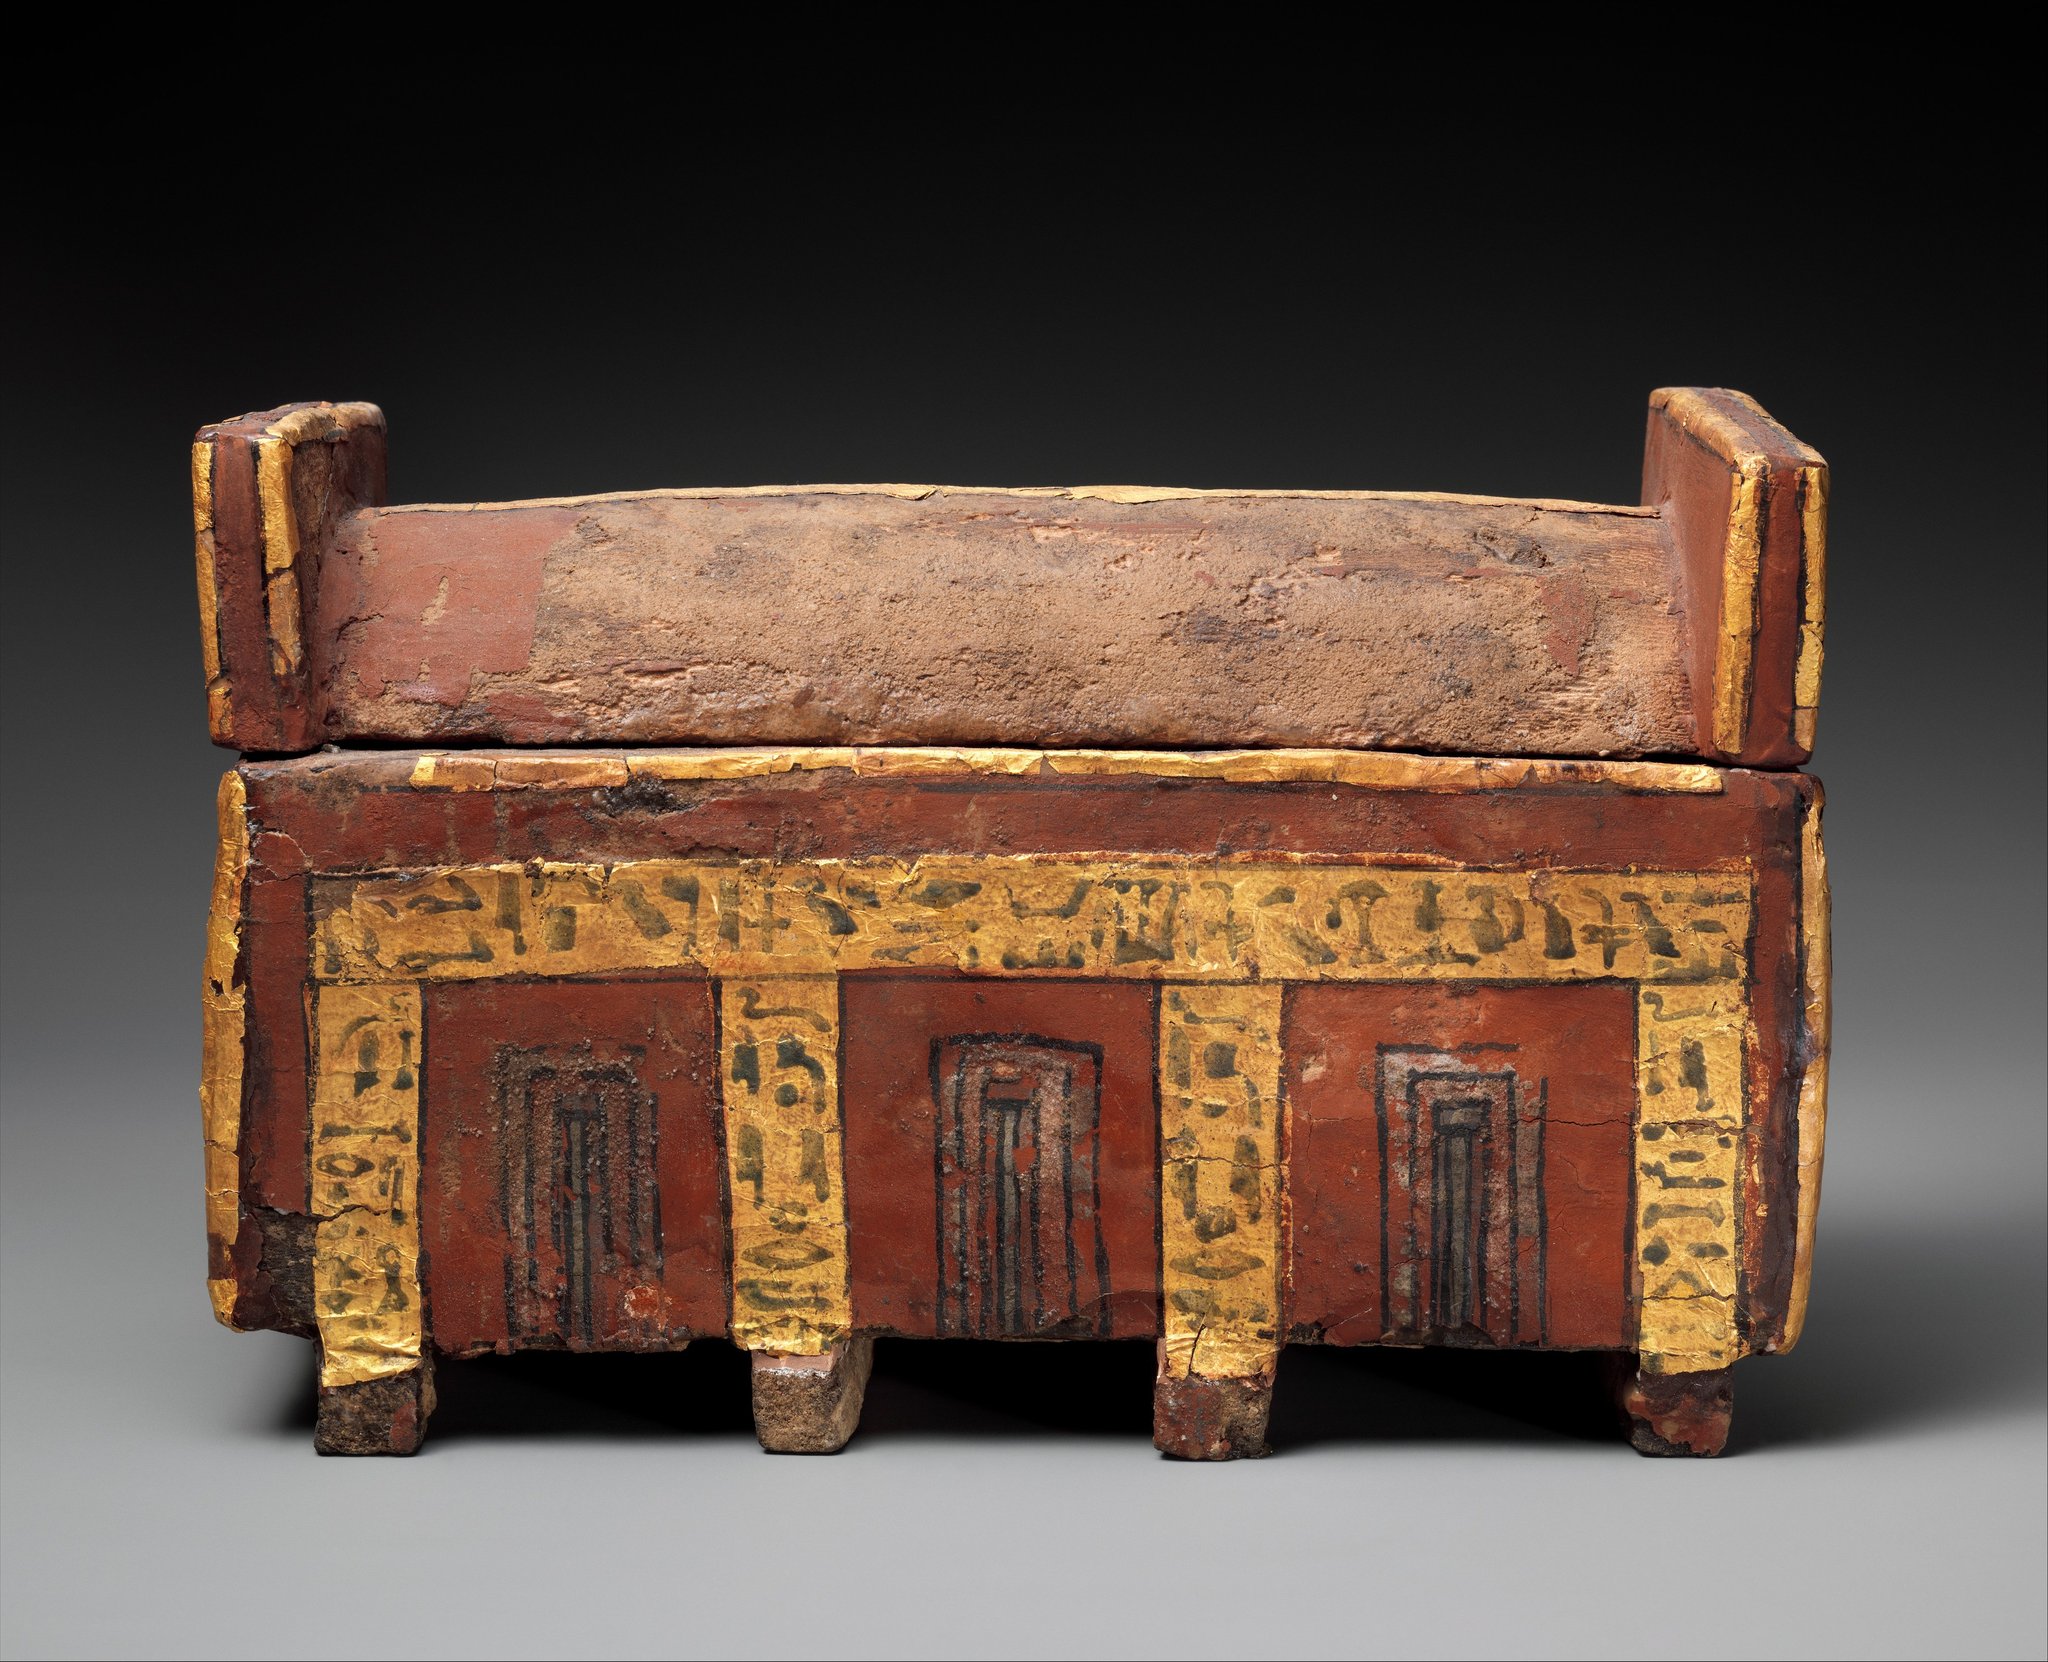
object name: shabti coffin, wahneferhotep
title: Shabti coffin of Wahneferhotep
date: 1981-1640 BCE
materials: gold leaf, paint, wood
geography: egypt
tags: coffins